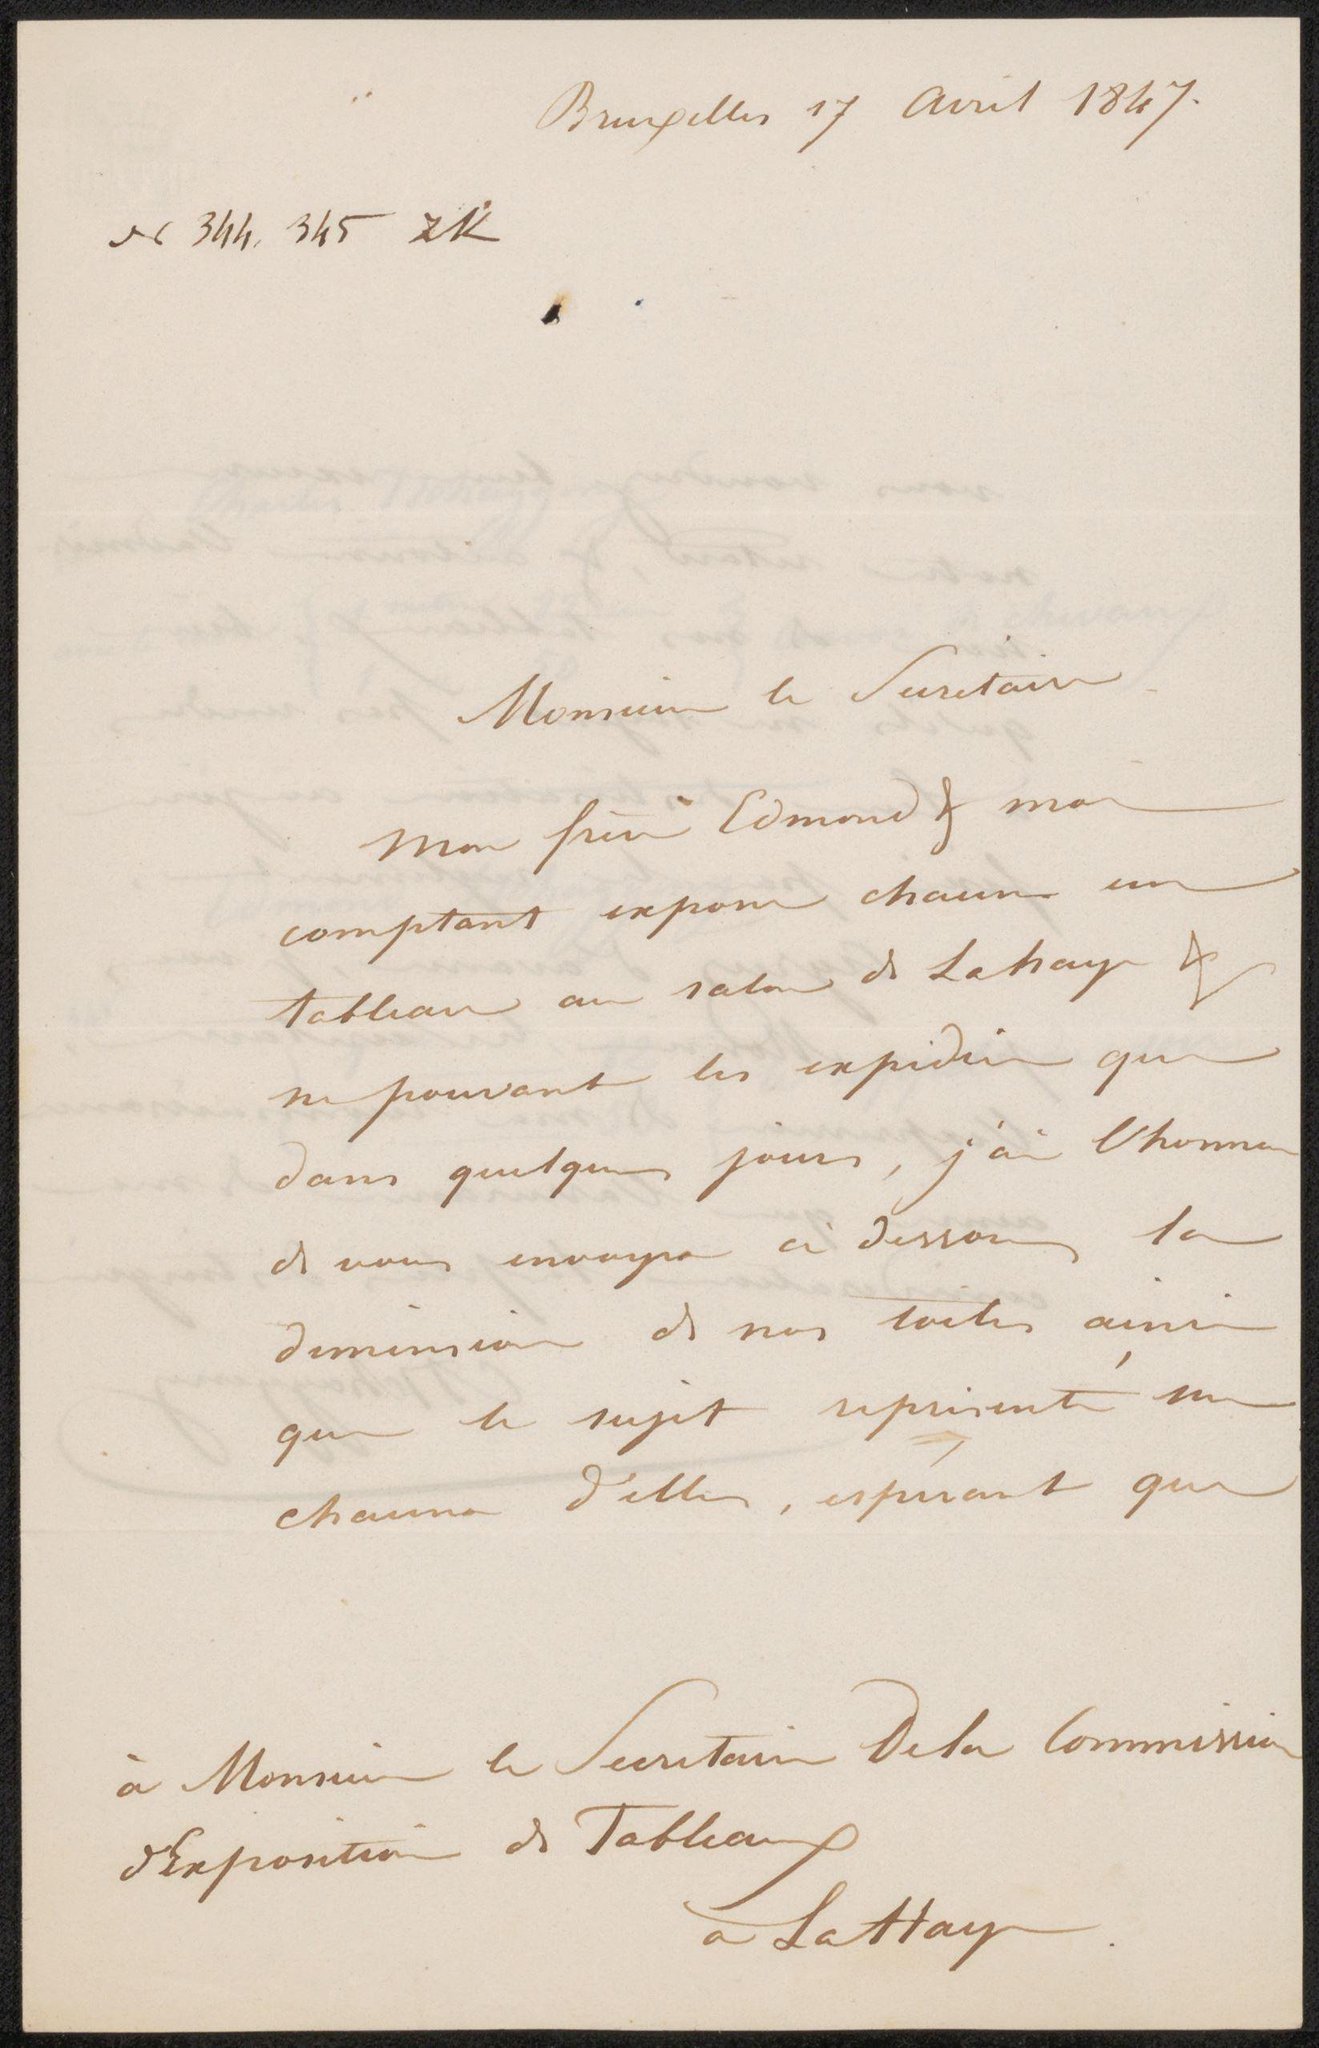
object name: letter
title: Brief aan de commissie van de Tentoonstelling van Levende Meesters in Den Haag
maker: charles tschaggeny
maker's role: print maker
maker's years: 1815-1894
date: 1847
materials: ink, paper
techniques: pen, writing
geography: brussels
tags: edmond tschaggeny, painting (including book-illumination, miniature-painting), exhibition ~ art